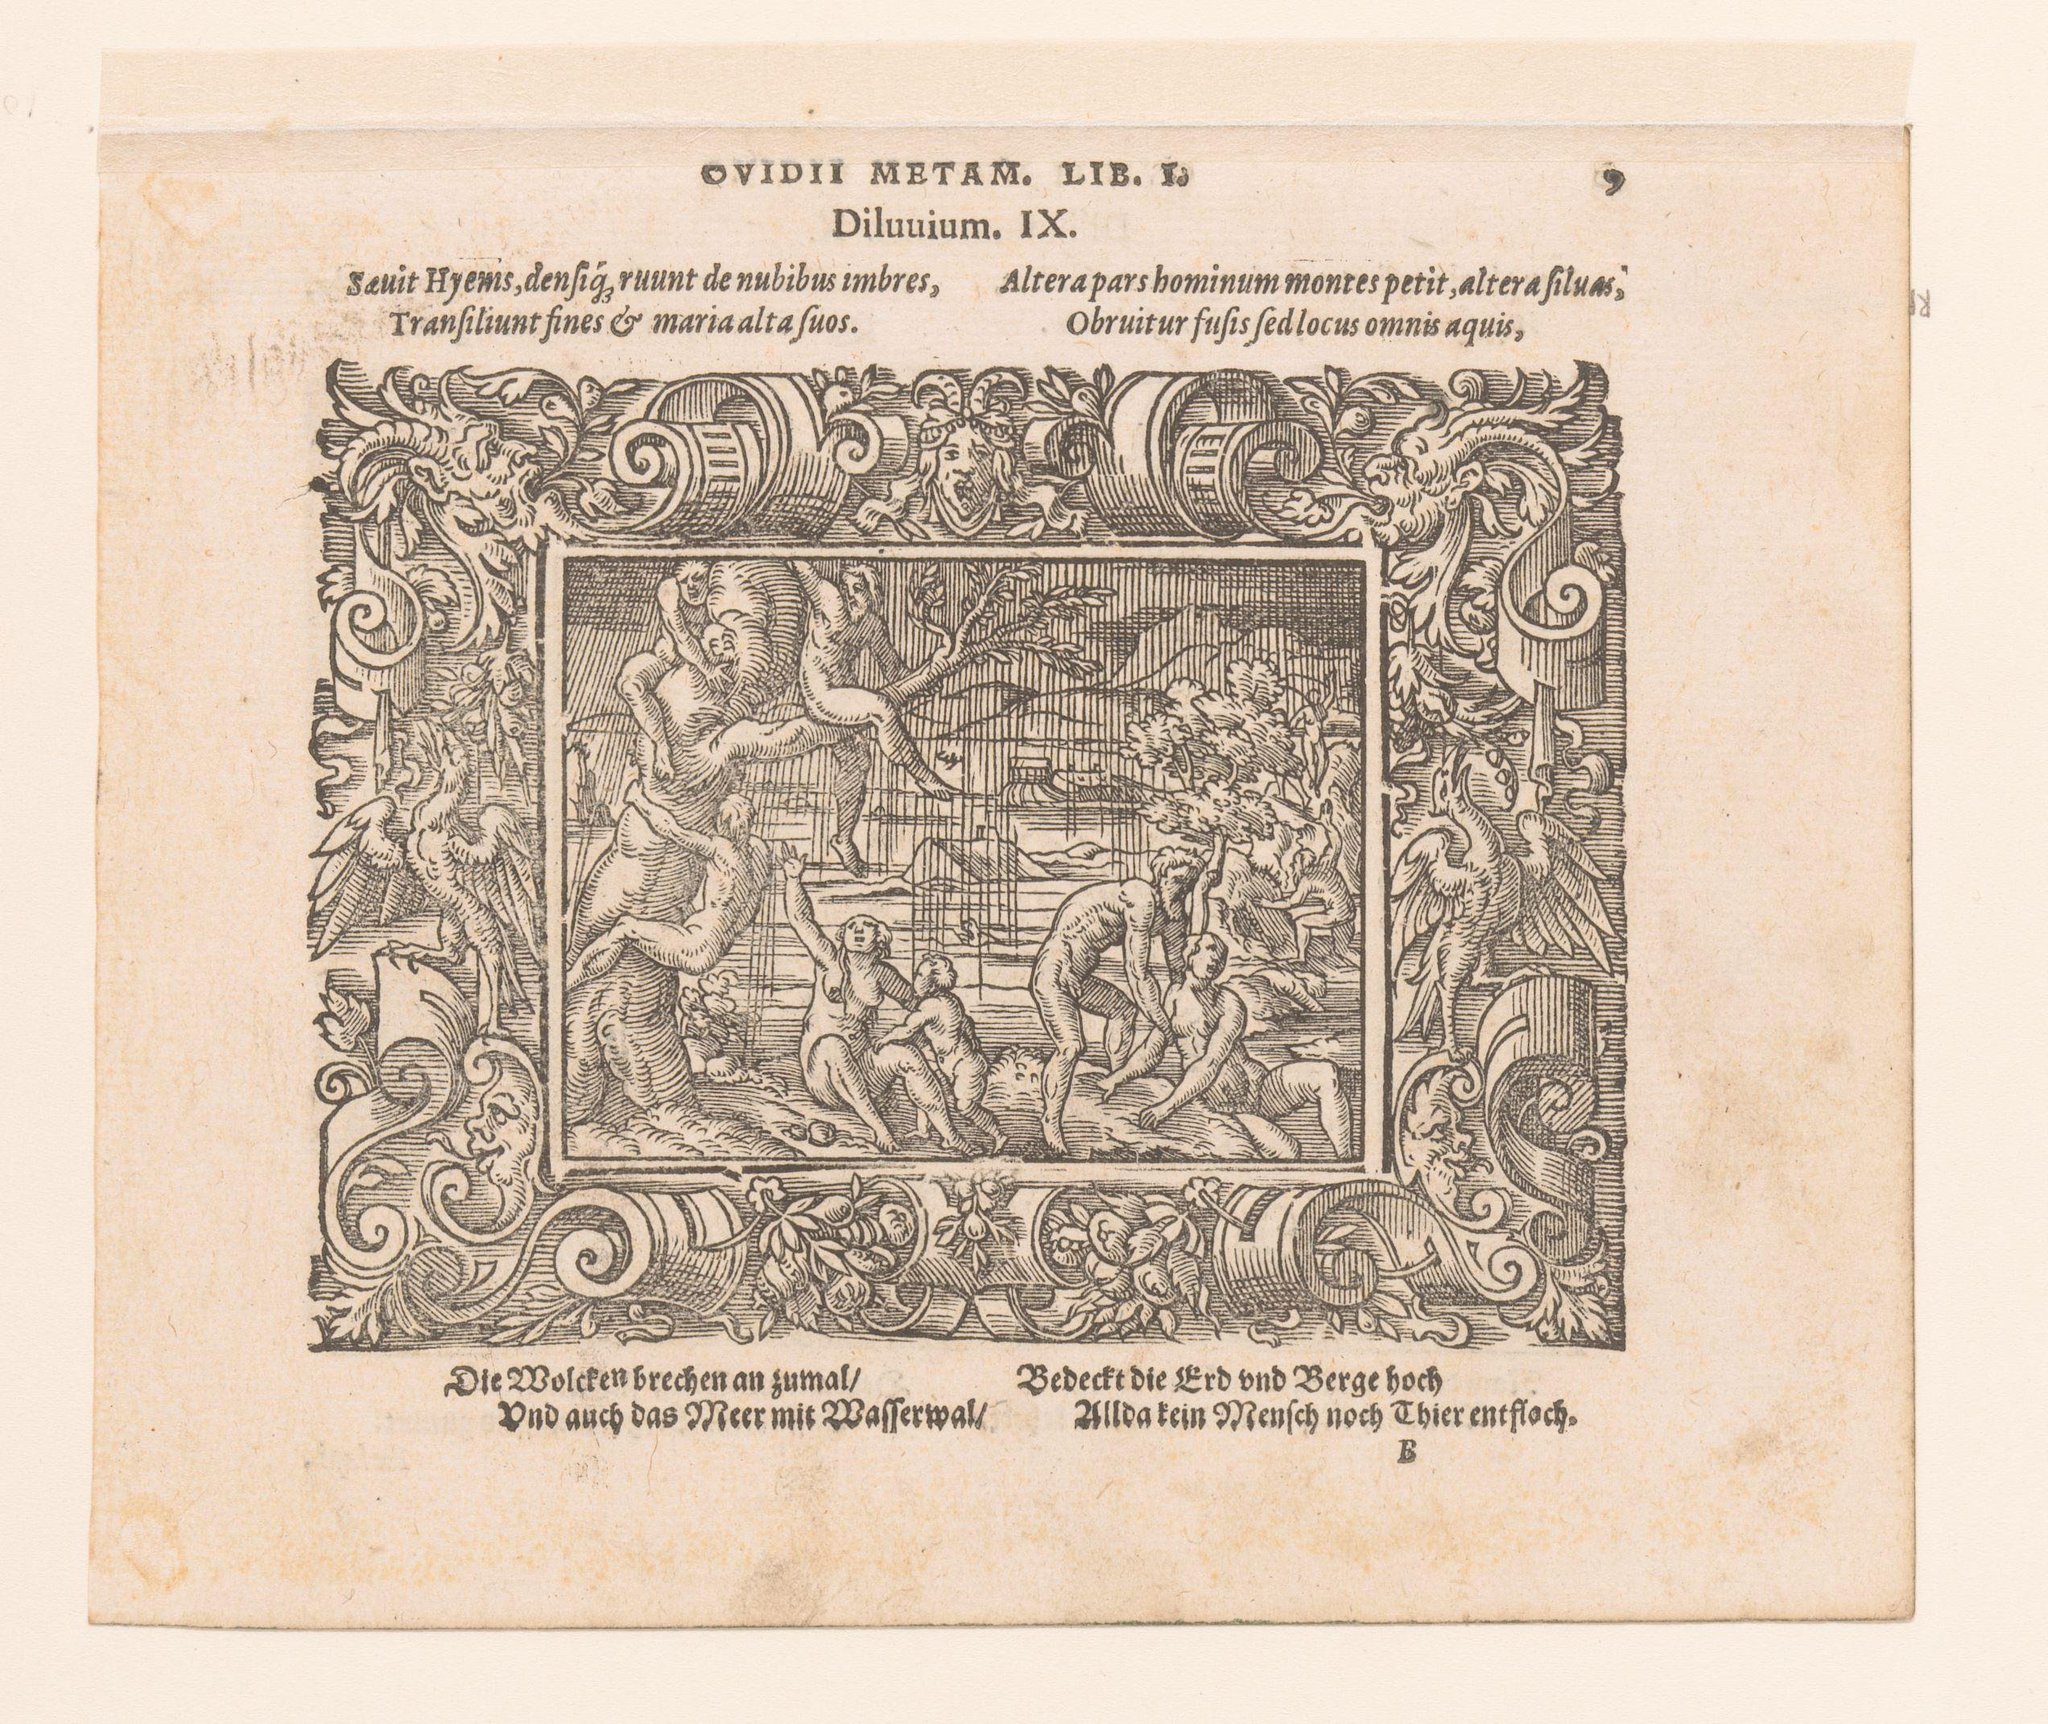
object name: book illustration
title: Zondvloed van Deucalion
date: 1569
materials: paper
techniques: letterpress printing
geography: frankfurt am main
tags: scrollwork, strapwork ~ ornament, deucalion's flood; jupiter sends a great flood to destroy mankind; deucalion and pyrrha afloat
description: Illustratie bij de Metamorfosen van Ovidius, afkomstig uit de publicatie: Posthius, Johannes. Tetrasticha in Ovidii metam. Frankfurt am Main: Georg Rab en Sigmund Feyerabend en erven Weigand Han, 1569. De voorstellingen en ornamentranden van deze boekillustraties zijn van twee aparte blokken gedrukt. Beide werden afzonderlijk van elkaar ook gebruikt voor andere publicaties, en de ornamentranden werden eveneens binnen deze publicatie meerdere keren gebruikt.